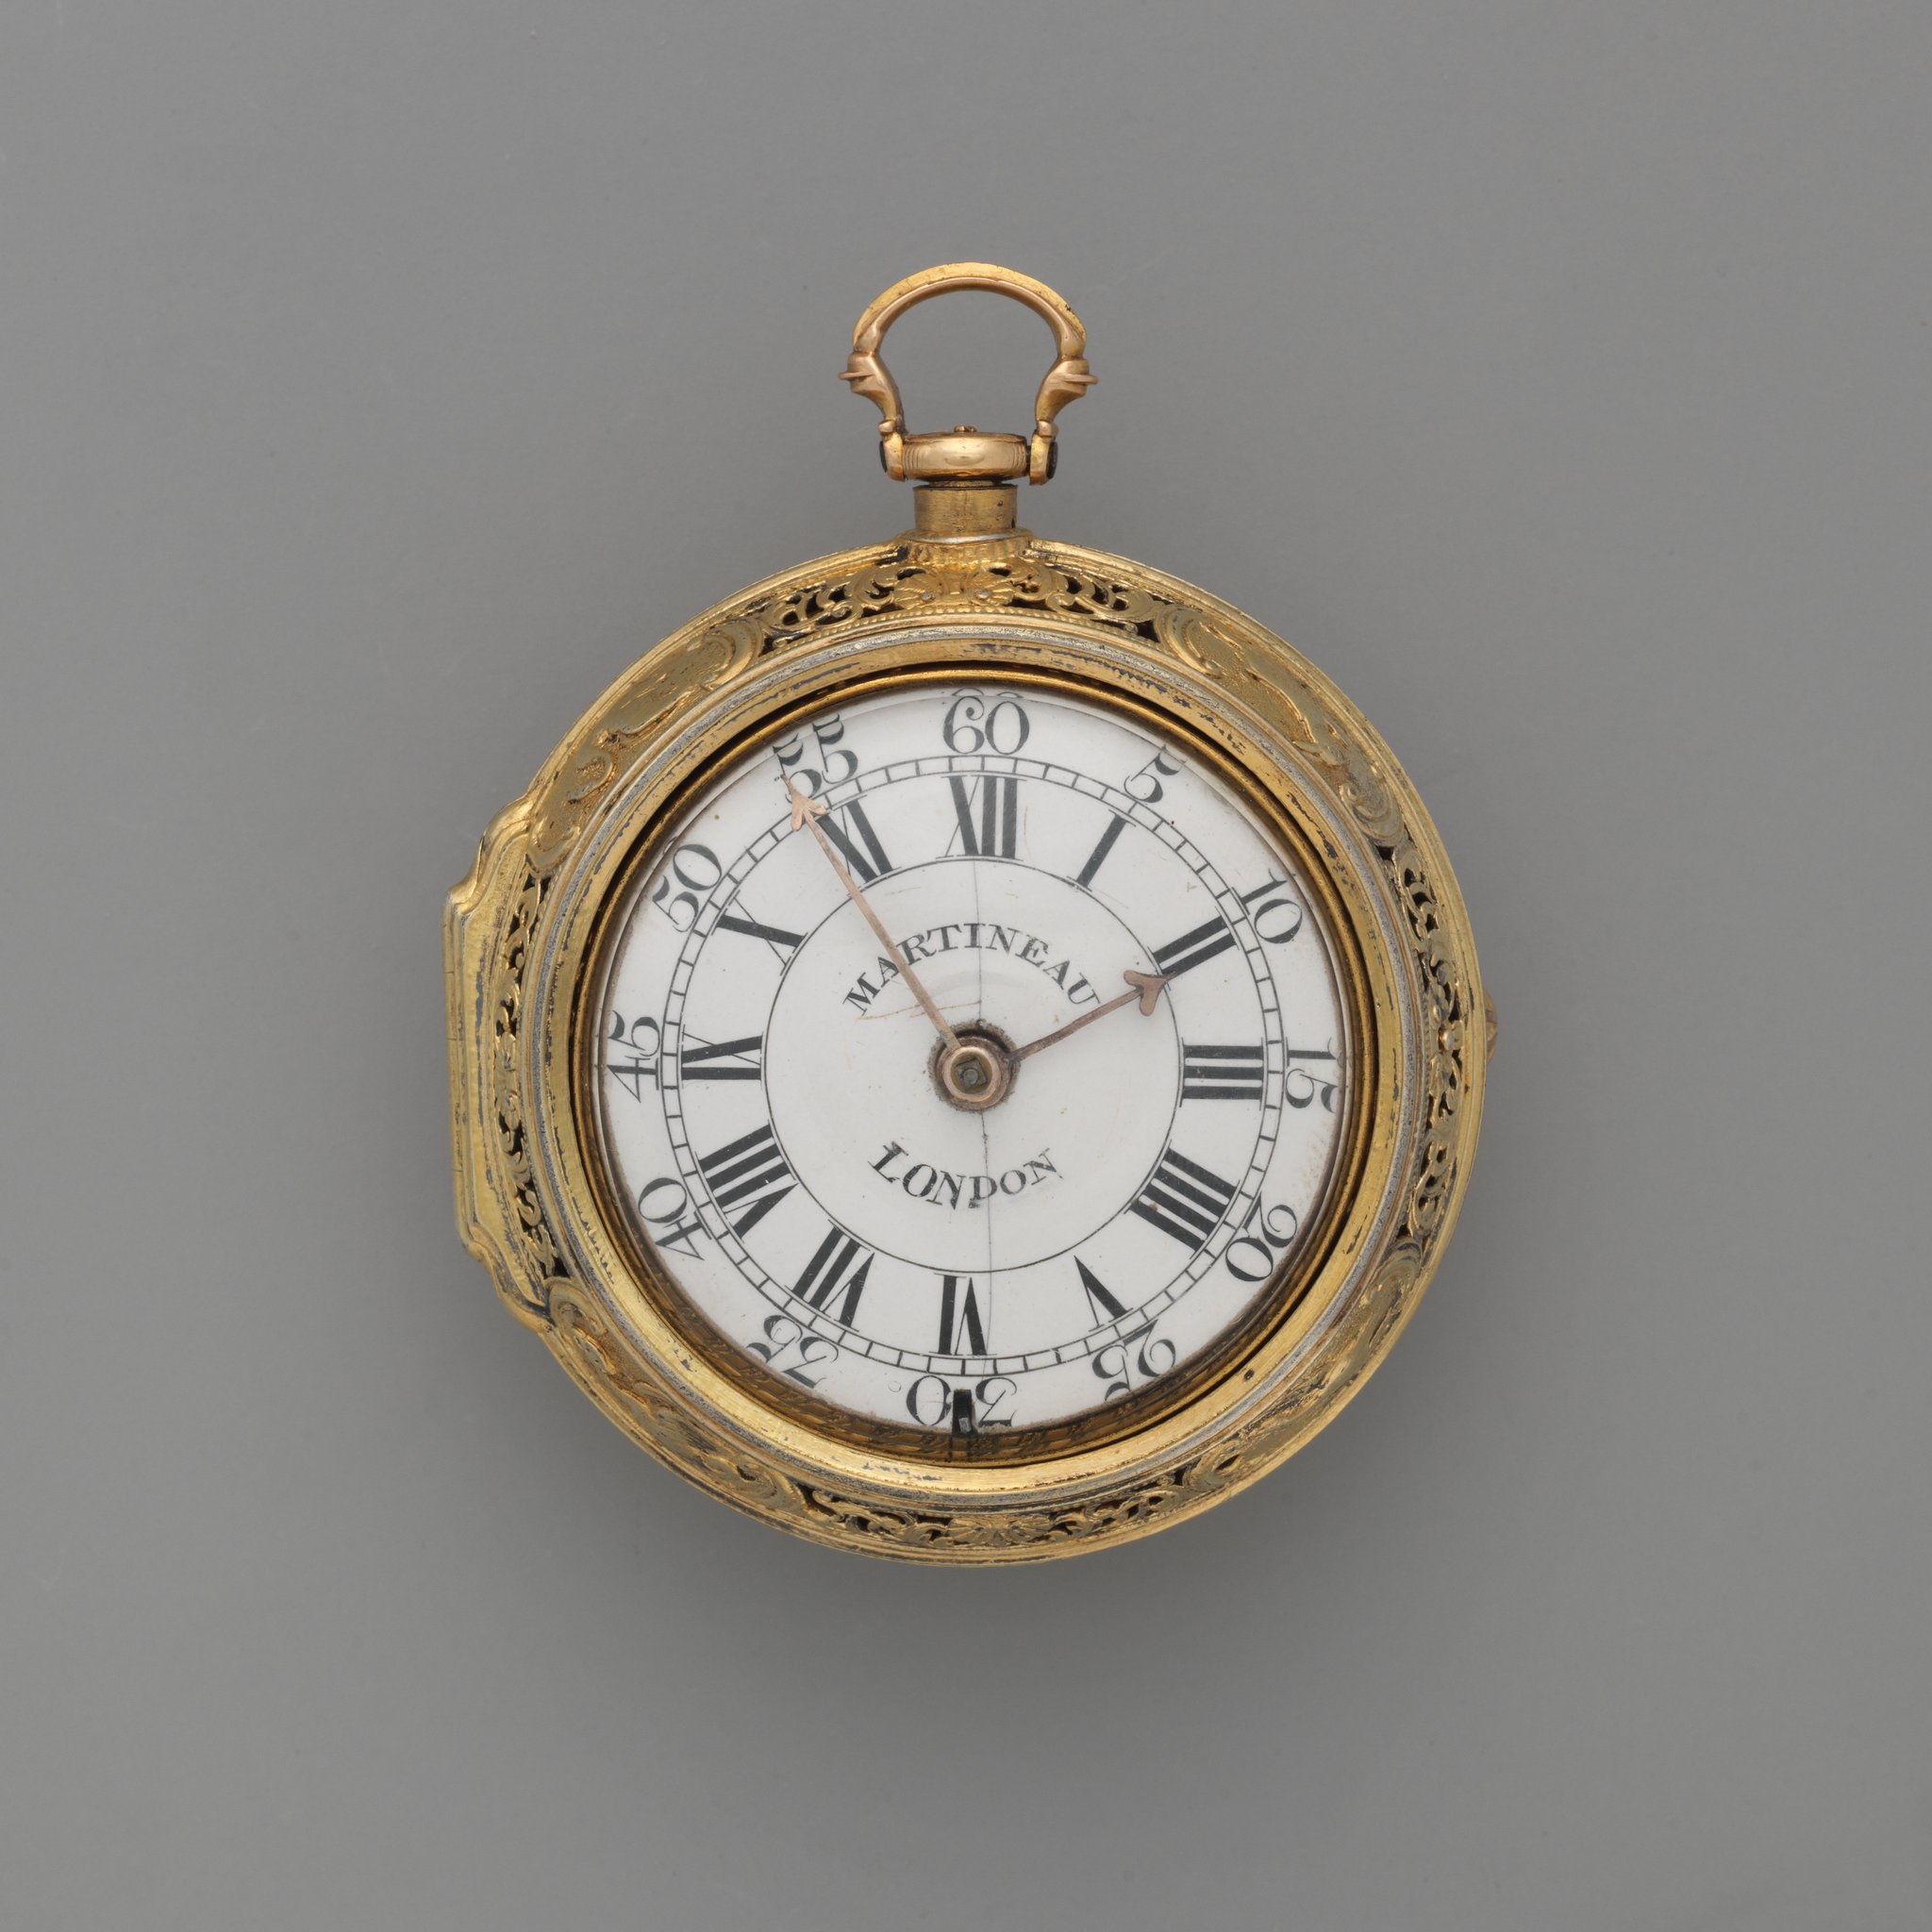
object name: clock watch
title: Clock-watch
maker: joseph martineau, sr.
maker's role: maker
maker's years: 1744-1794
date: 1760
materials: enamel, silver gilt